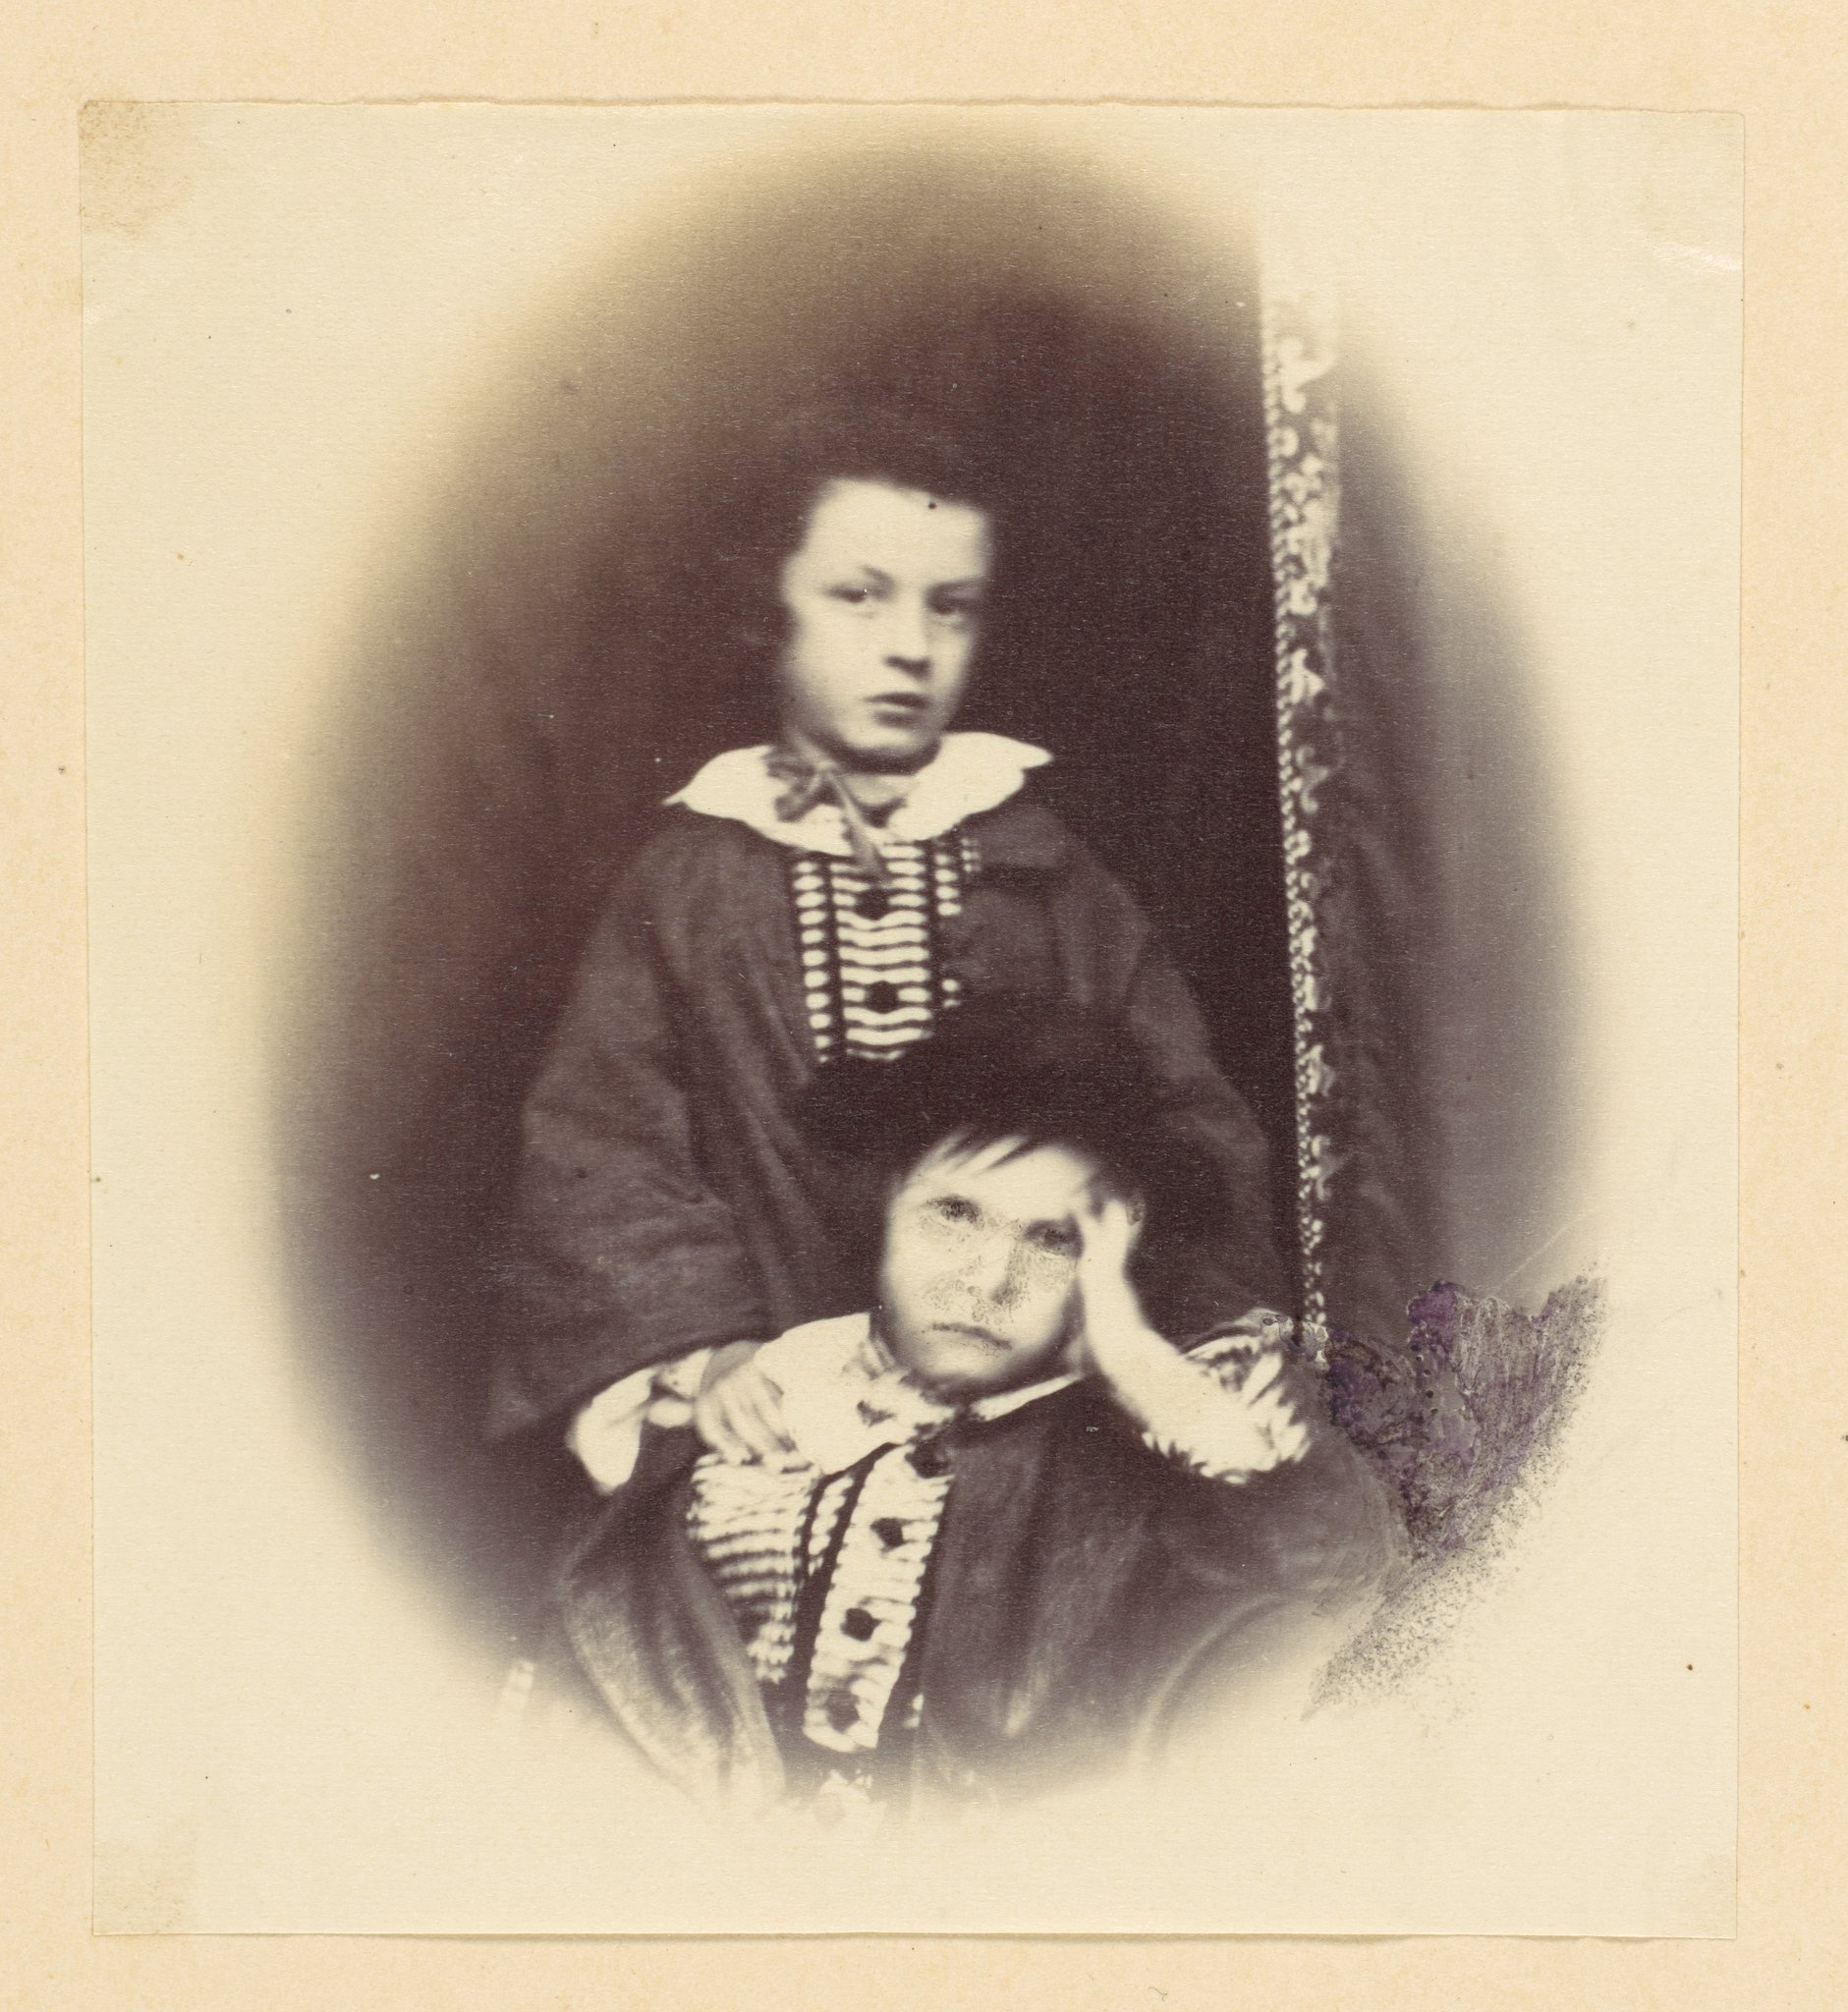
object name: photograph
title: [Vignetted portrait of two children]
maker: alfred capel cure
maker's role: artist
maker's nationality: british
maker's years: 1826-1896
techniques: albumen silver print, paper negative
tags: children,portraits